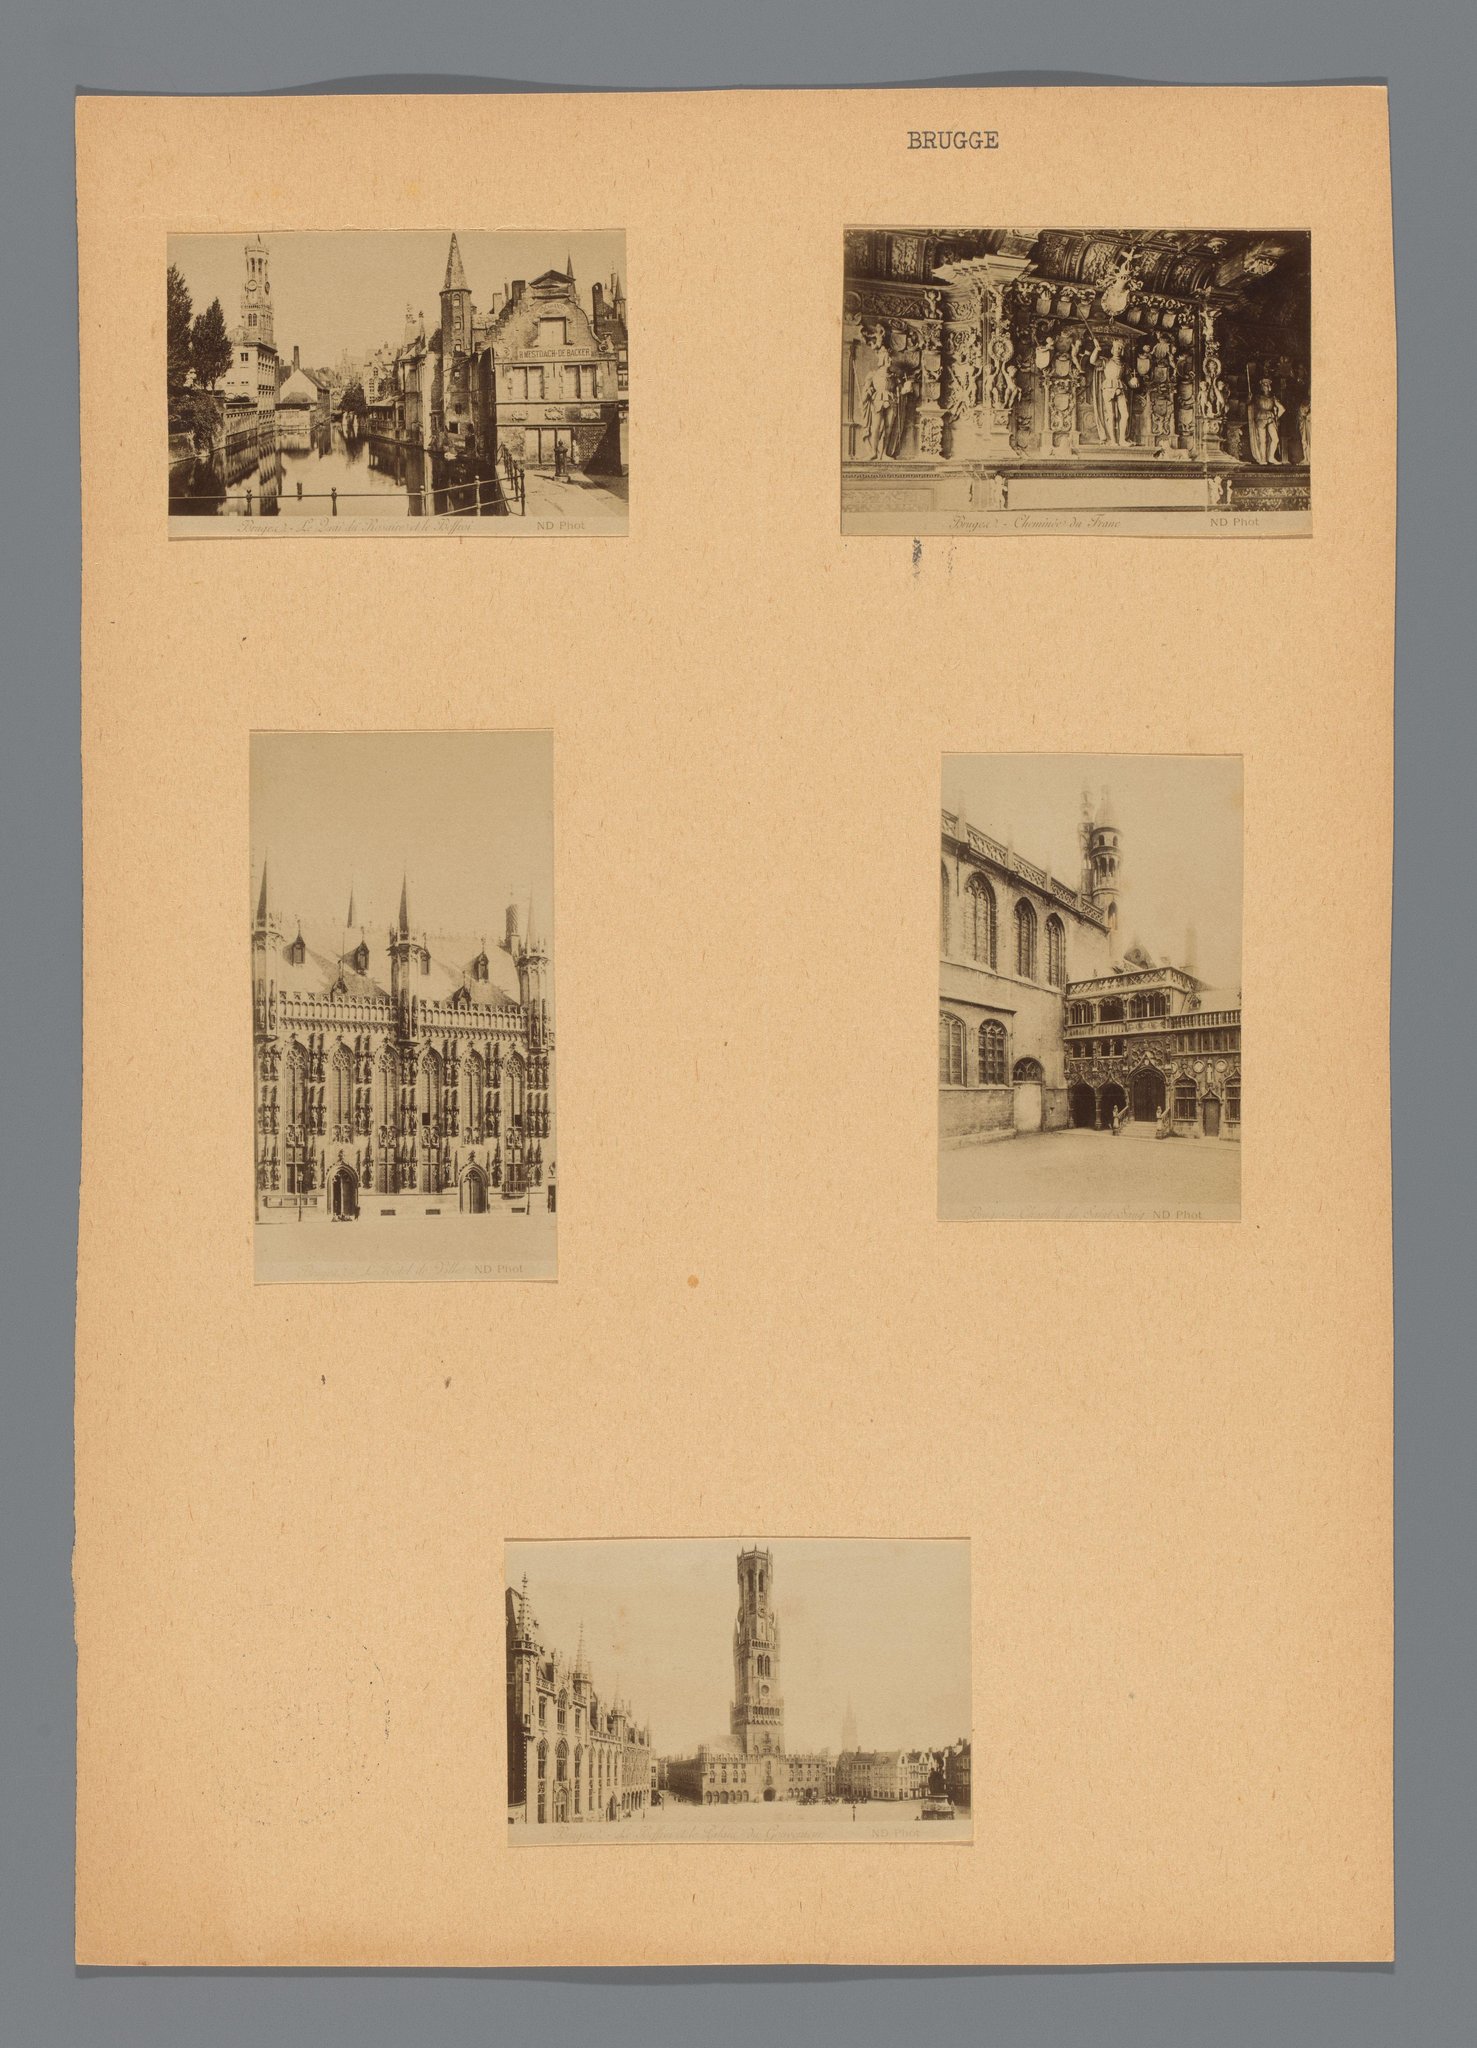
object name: photograph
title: Brugge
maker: Anonymous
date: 1850-1900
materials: photographic support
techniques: albumen print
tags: bruges